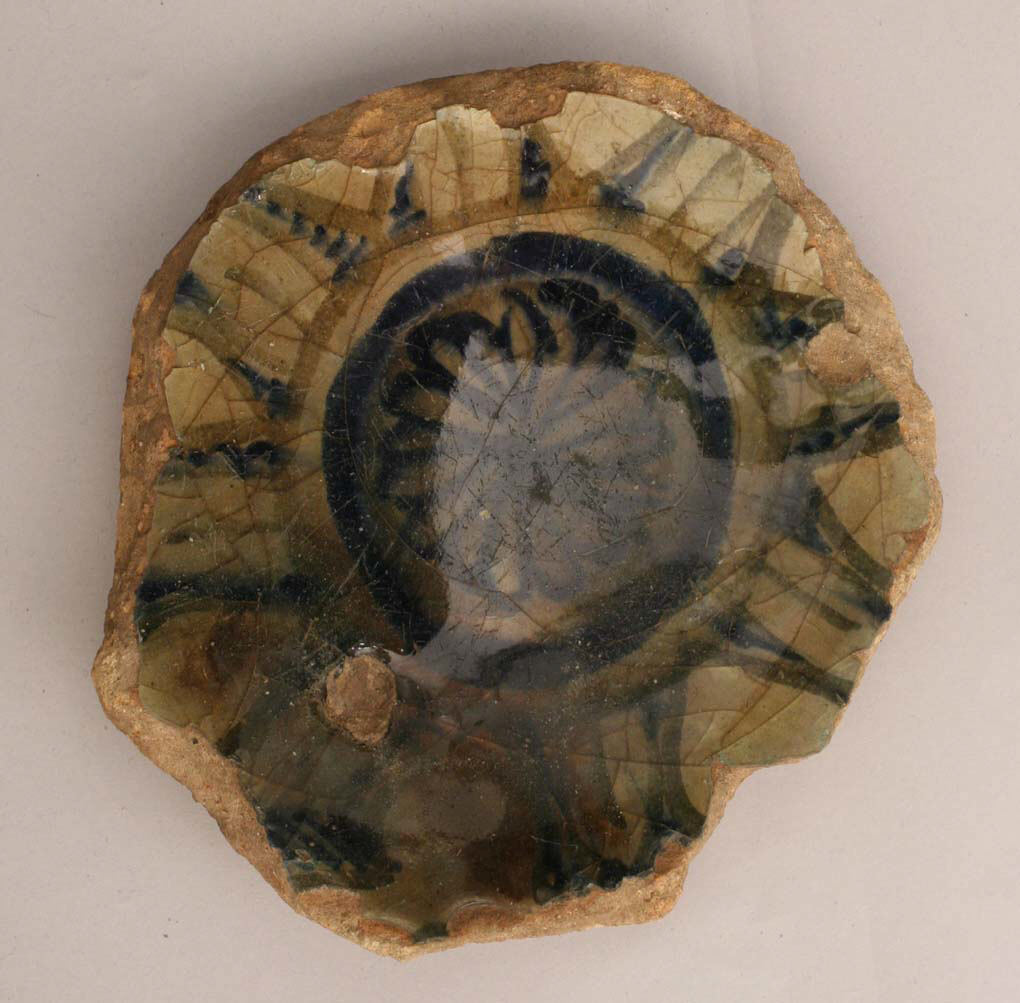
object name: fragment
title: Fragment of a Bowl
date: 1401-1500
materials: earthenware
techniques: painting, underglaze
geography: egypt